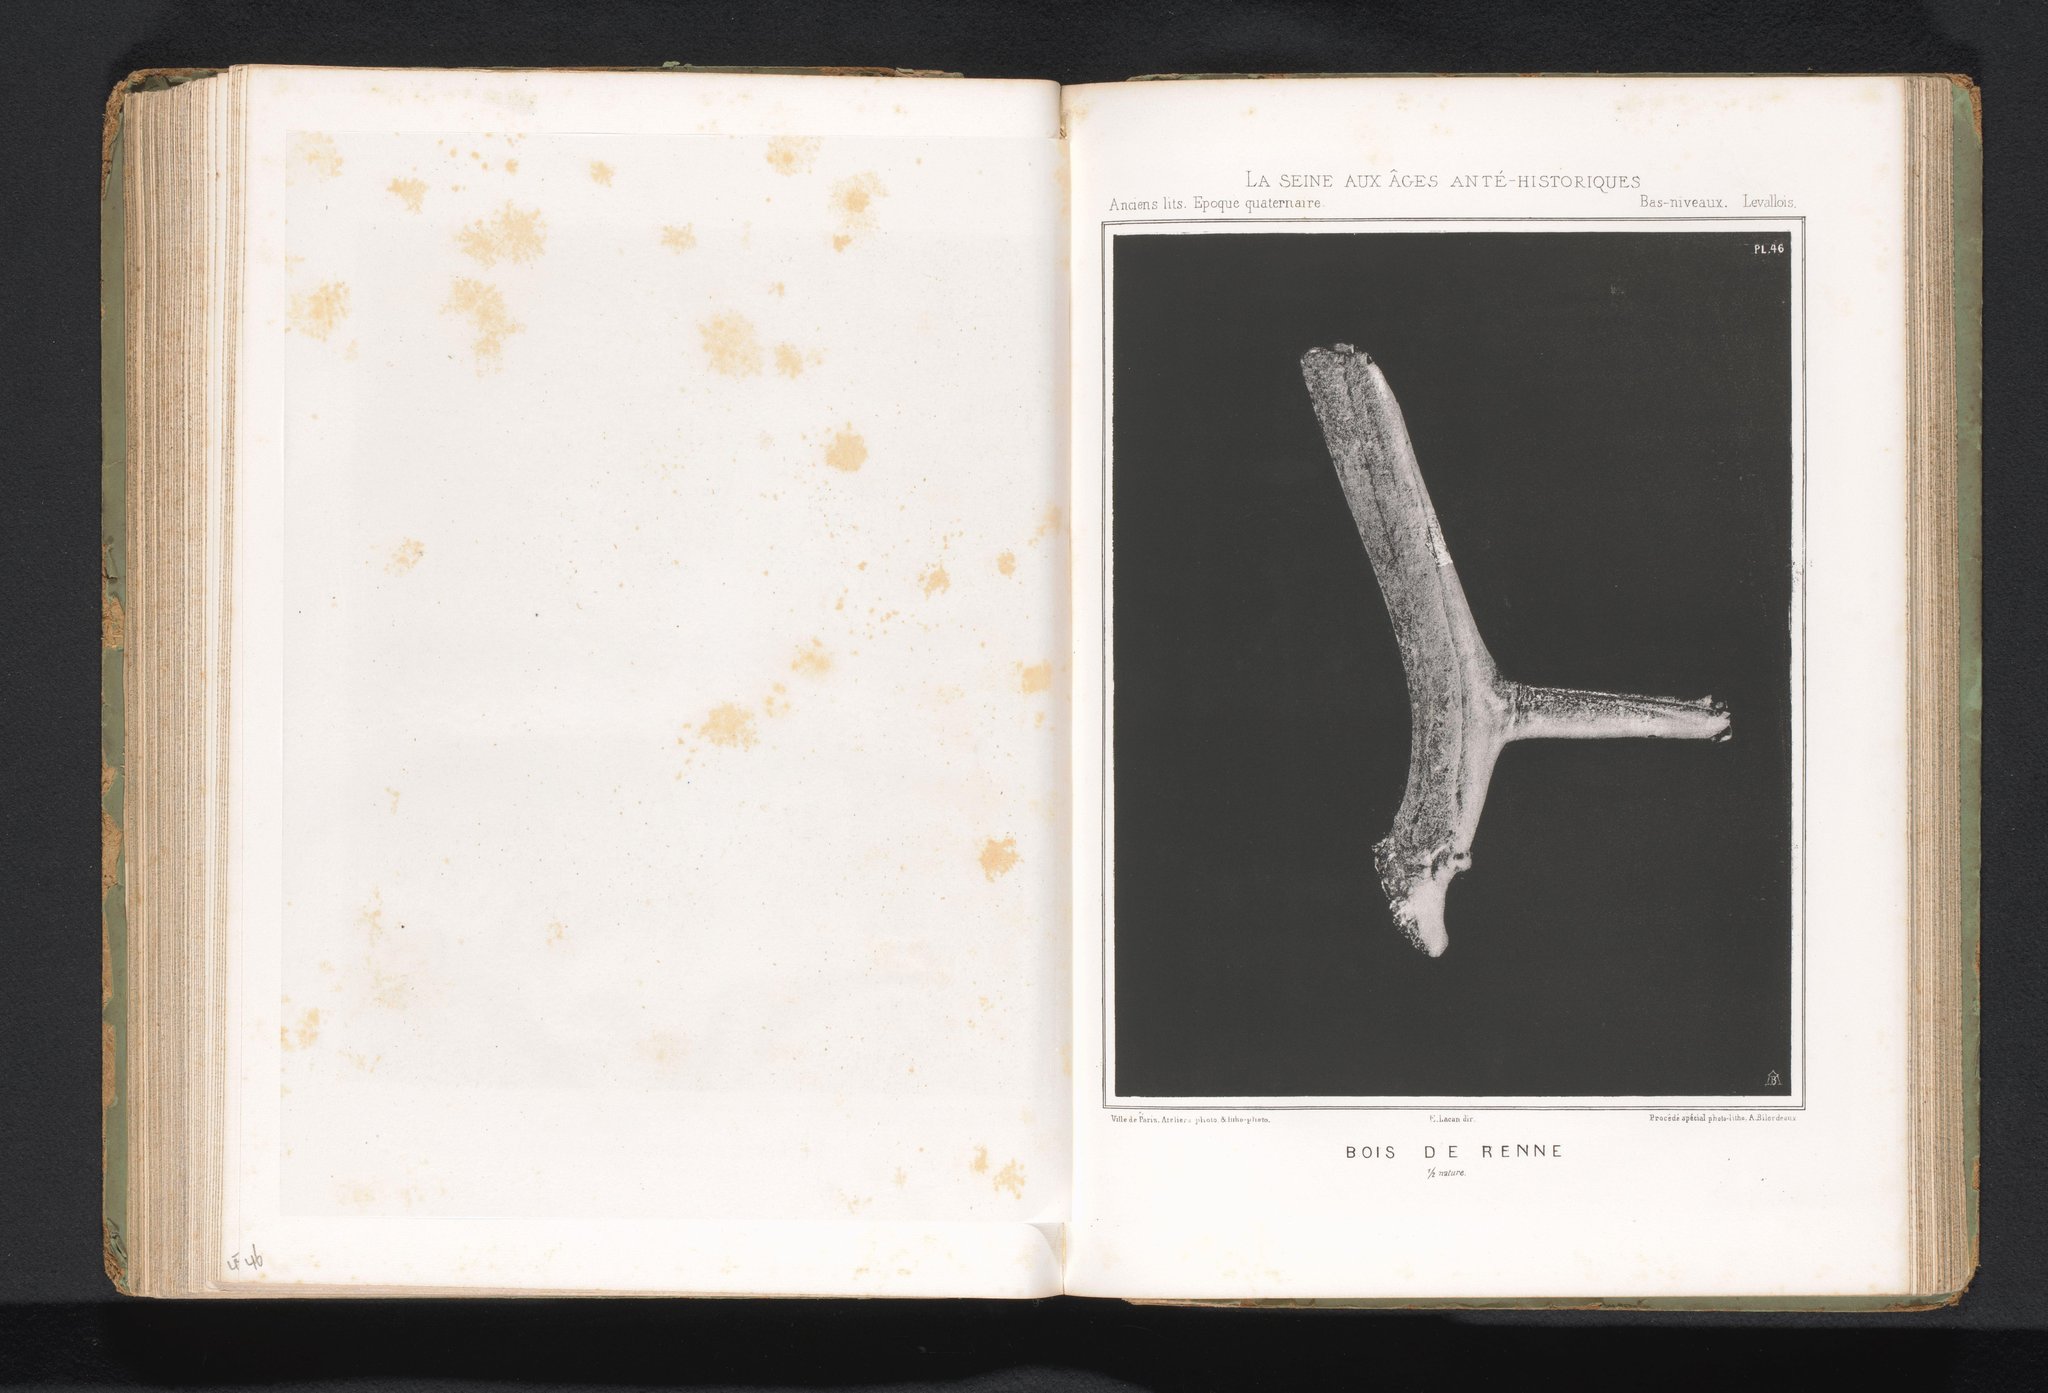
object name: page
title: Bot van een rendier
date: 1864-1869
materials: paper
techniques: photolithography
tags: animals (+ skeleton of an animal), palaeontology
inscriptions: inscription: ‘Procédé spécial photo-litho. A. Bilordeaux’, inscription: ‘PL. 46’, monogram: ‘AB’, inscription: ‘1/2 nature’